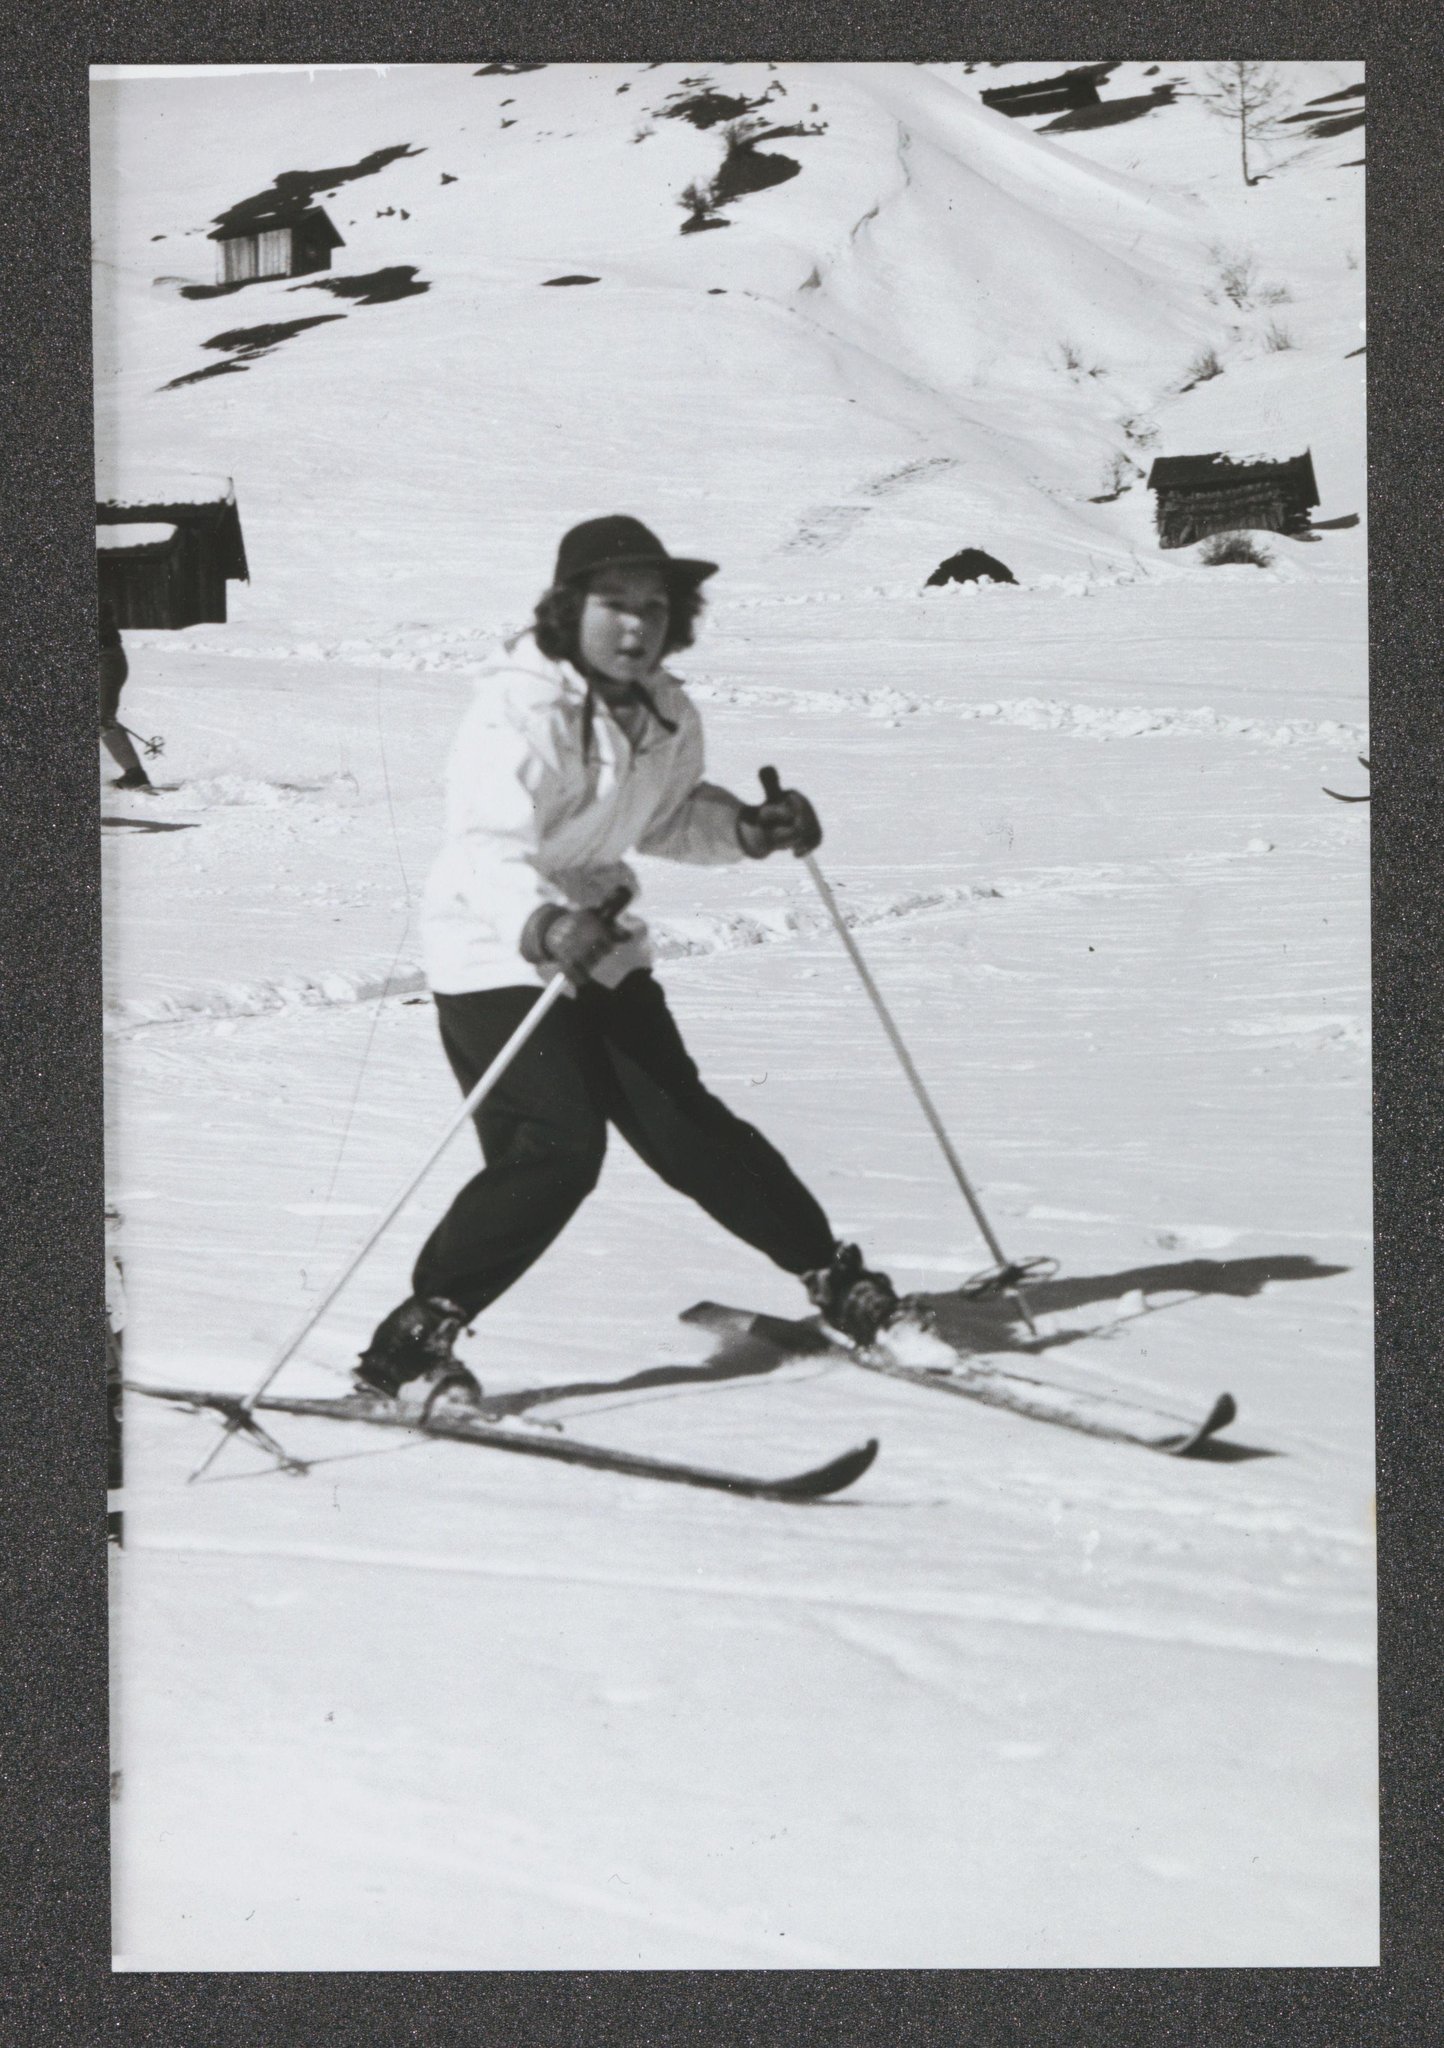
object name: photograph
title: Prinses Beatrix op ski's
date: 1959-1969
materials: photographic support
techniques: gelatin silver print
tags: beatrix (koningin der nederlanden)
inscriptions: inscription: ‘Saturday 31st, 1959 ... het majority. Picutre from the files ... enjoying ski sport. Photo ANEFO 28-1-1959’